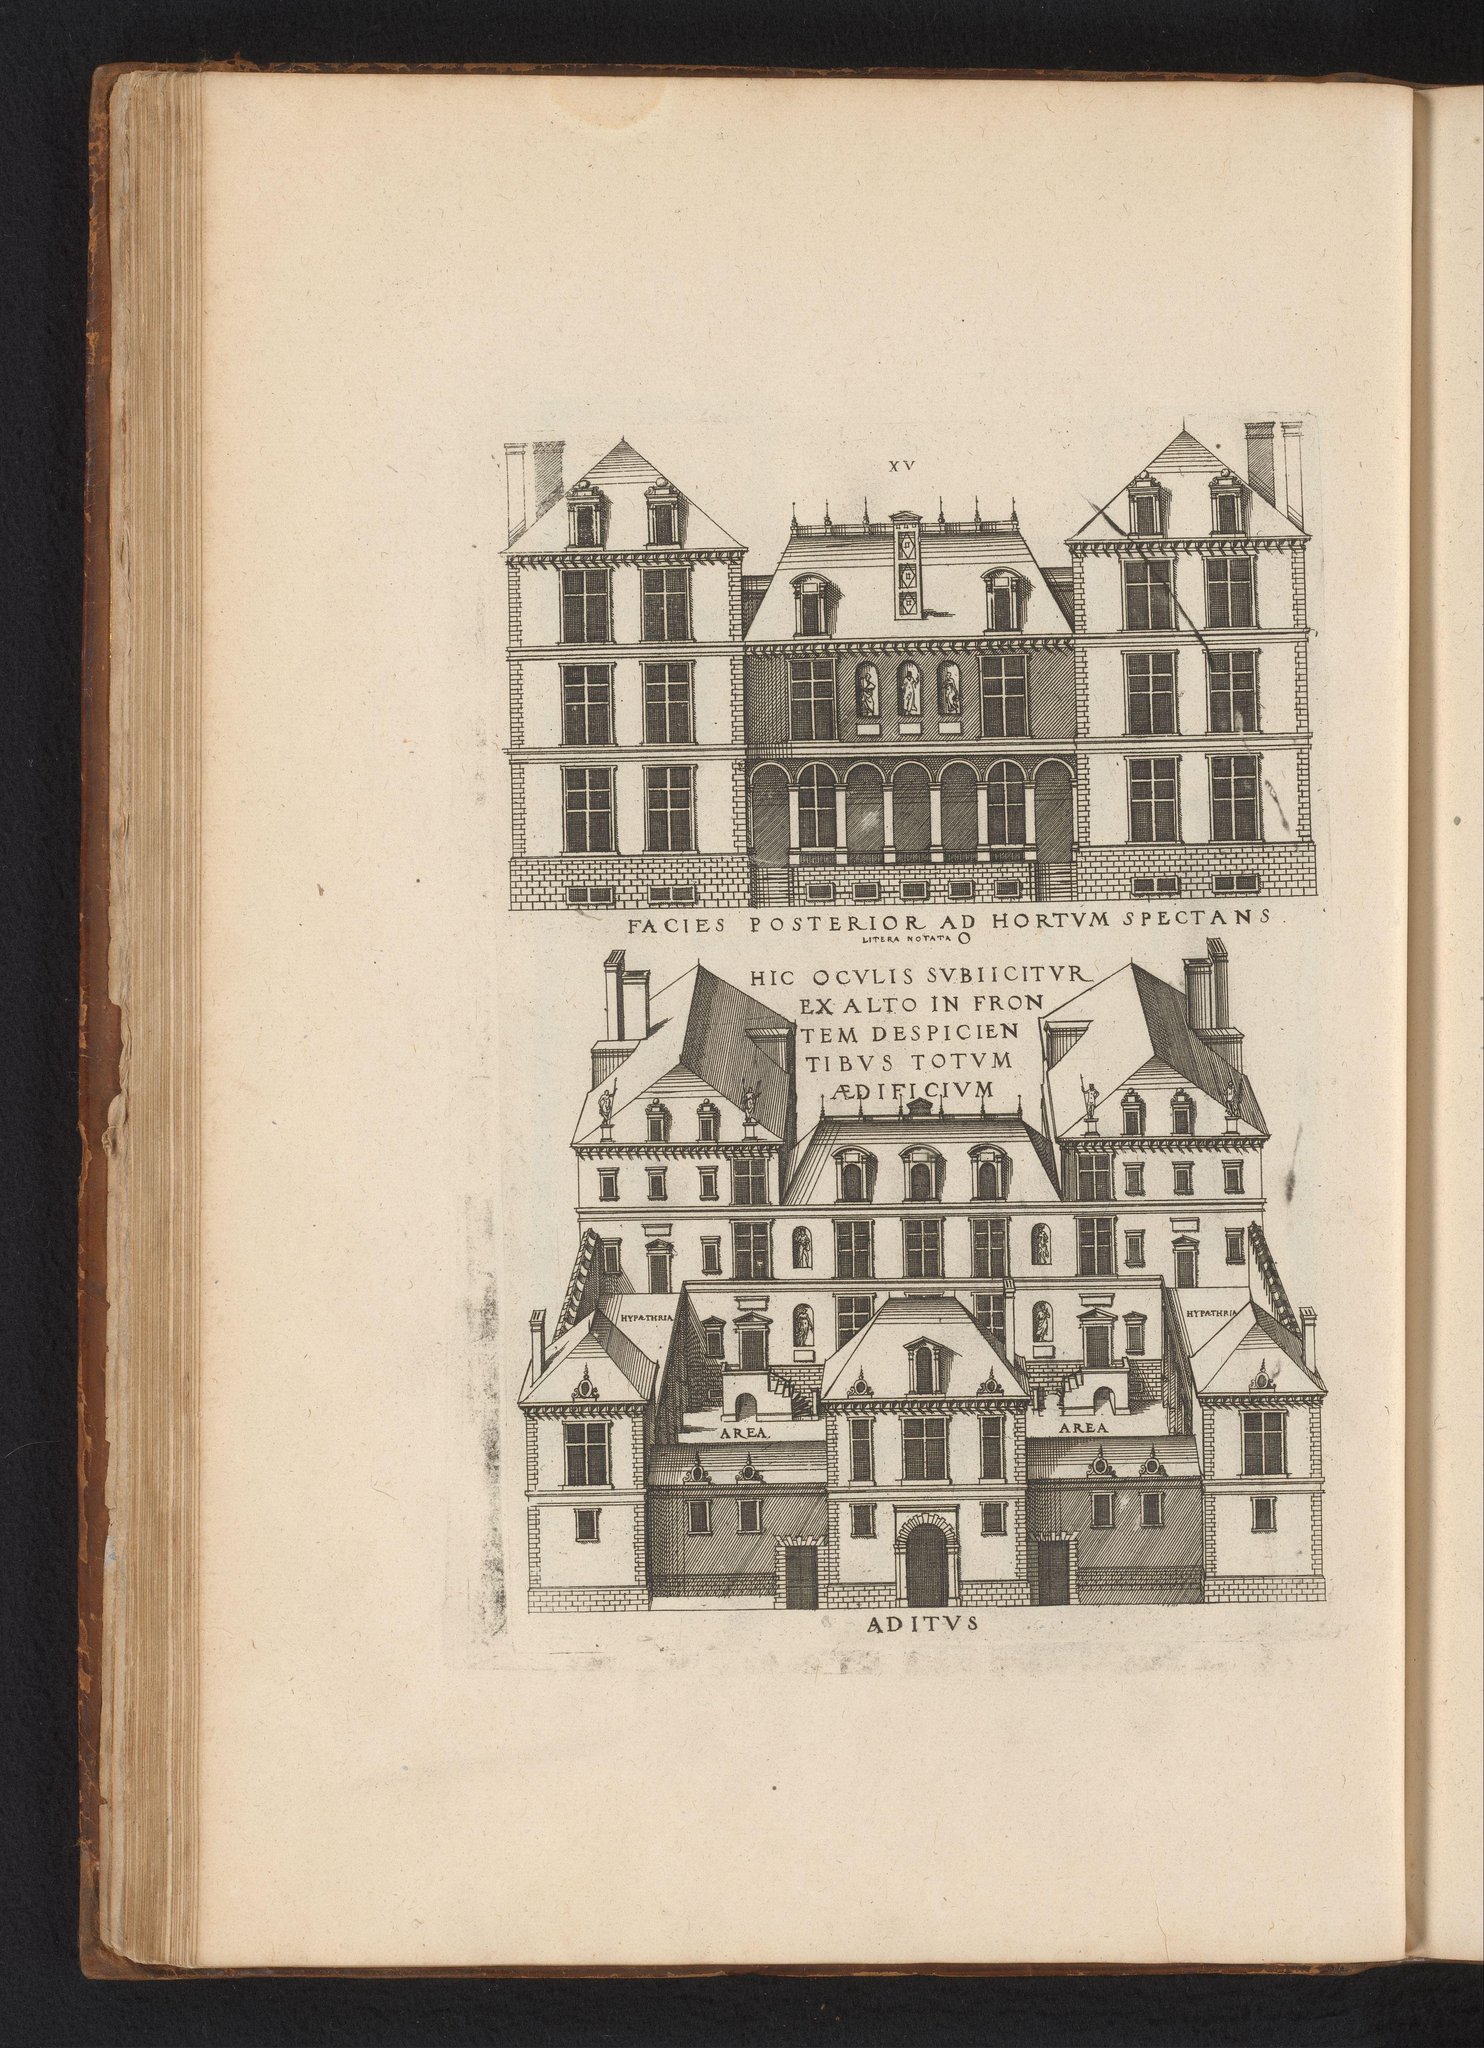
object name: ornament print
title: Achtergevel en vogelvluchtperspectief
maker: jacques androuet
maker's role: draughtsman, print maker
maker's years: 1515-1584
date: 1559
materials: paper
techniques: etching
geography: paris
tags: bird's eye view ~ representation of building, façade (of house or building)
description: Achtergevel en vogelvluchtperspectief van architectuur. Genummerd: XV. Onderdeel van 'De architectura Iacobi Androuetii du Cerceau' (1559): 69 etsen met 171 voorstellingen van architectuur en ornamentiek.